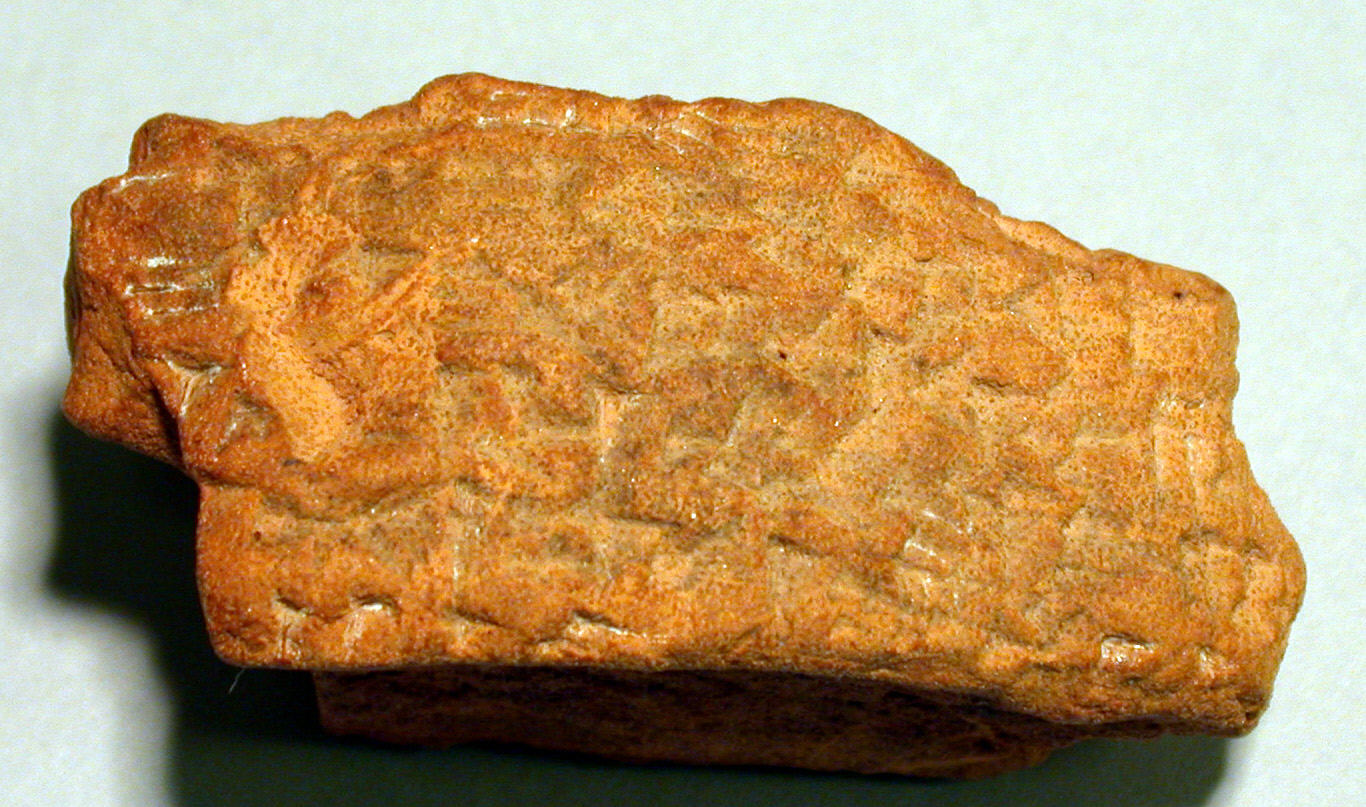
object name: cuneiform tablet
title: Cuneiform tablet: fragment of a contract involving a house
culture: achaemenid or babylonian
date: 700-301 BCE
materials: clay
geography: mesopotamia